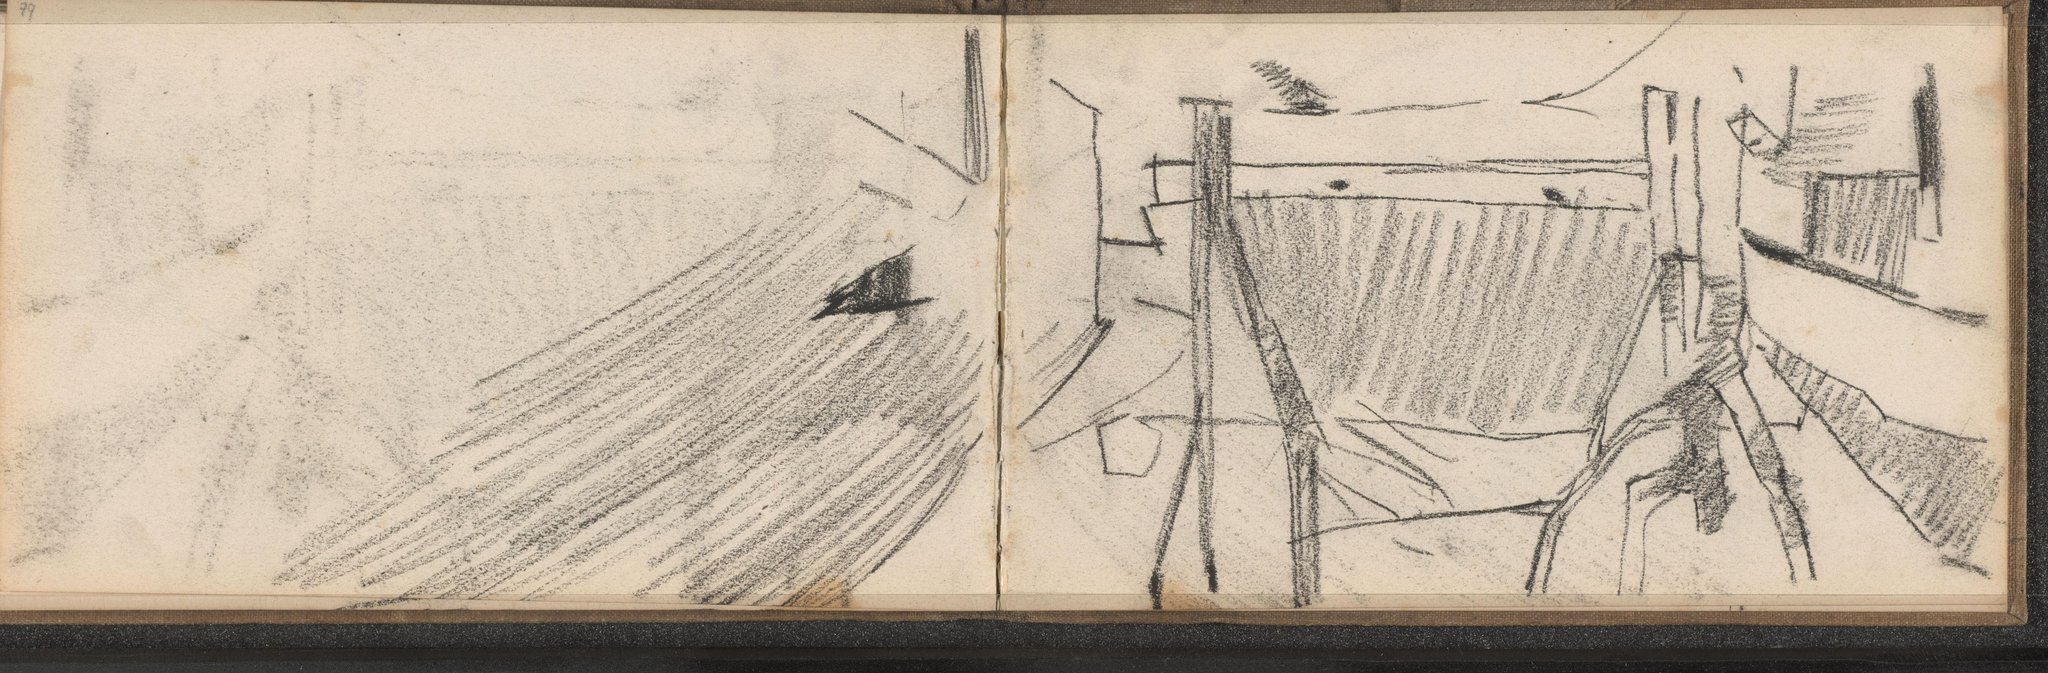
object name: sketchbook leaf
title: Boerderijen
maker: george hendrik breitner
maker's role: draughtsman, painter, print maker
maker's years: 1857-1923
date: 1883-1885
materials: chalk, paper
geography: drenthe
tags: barn, farm (building)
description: Pagina 79 en pagina 80 uit een schetsboek met 48 bladen.